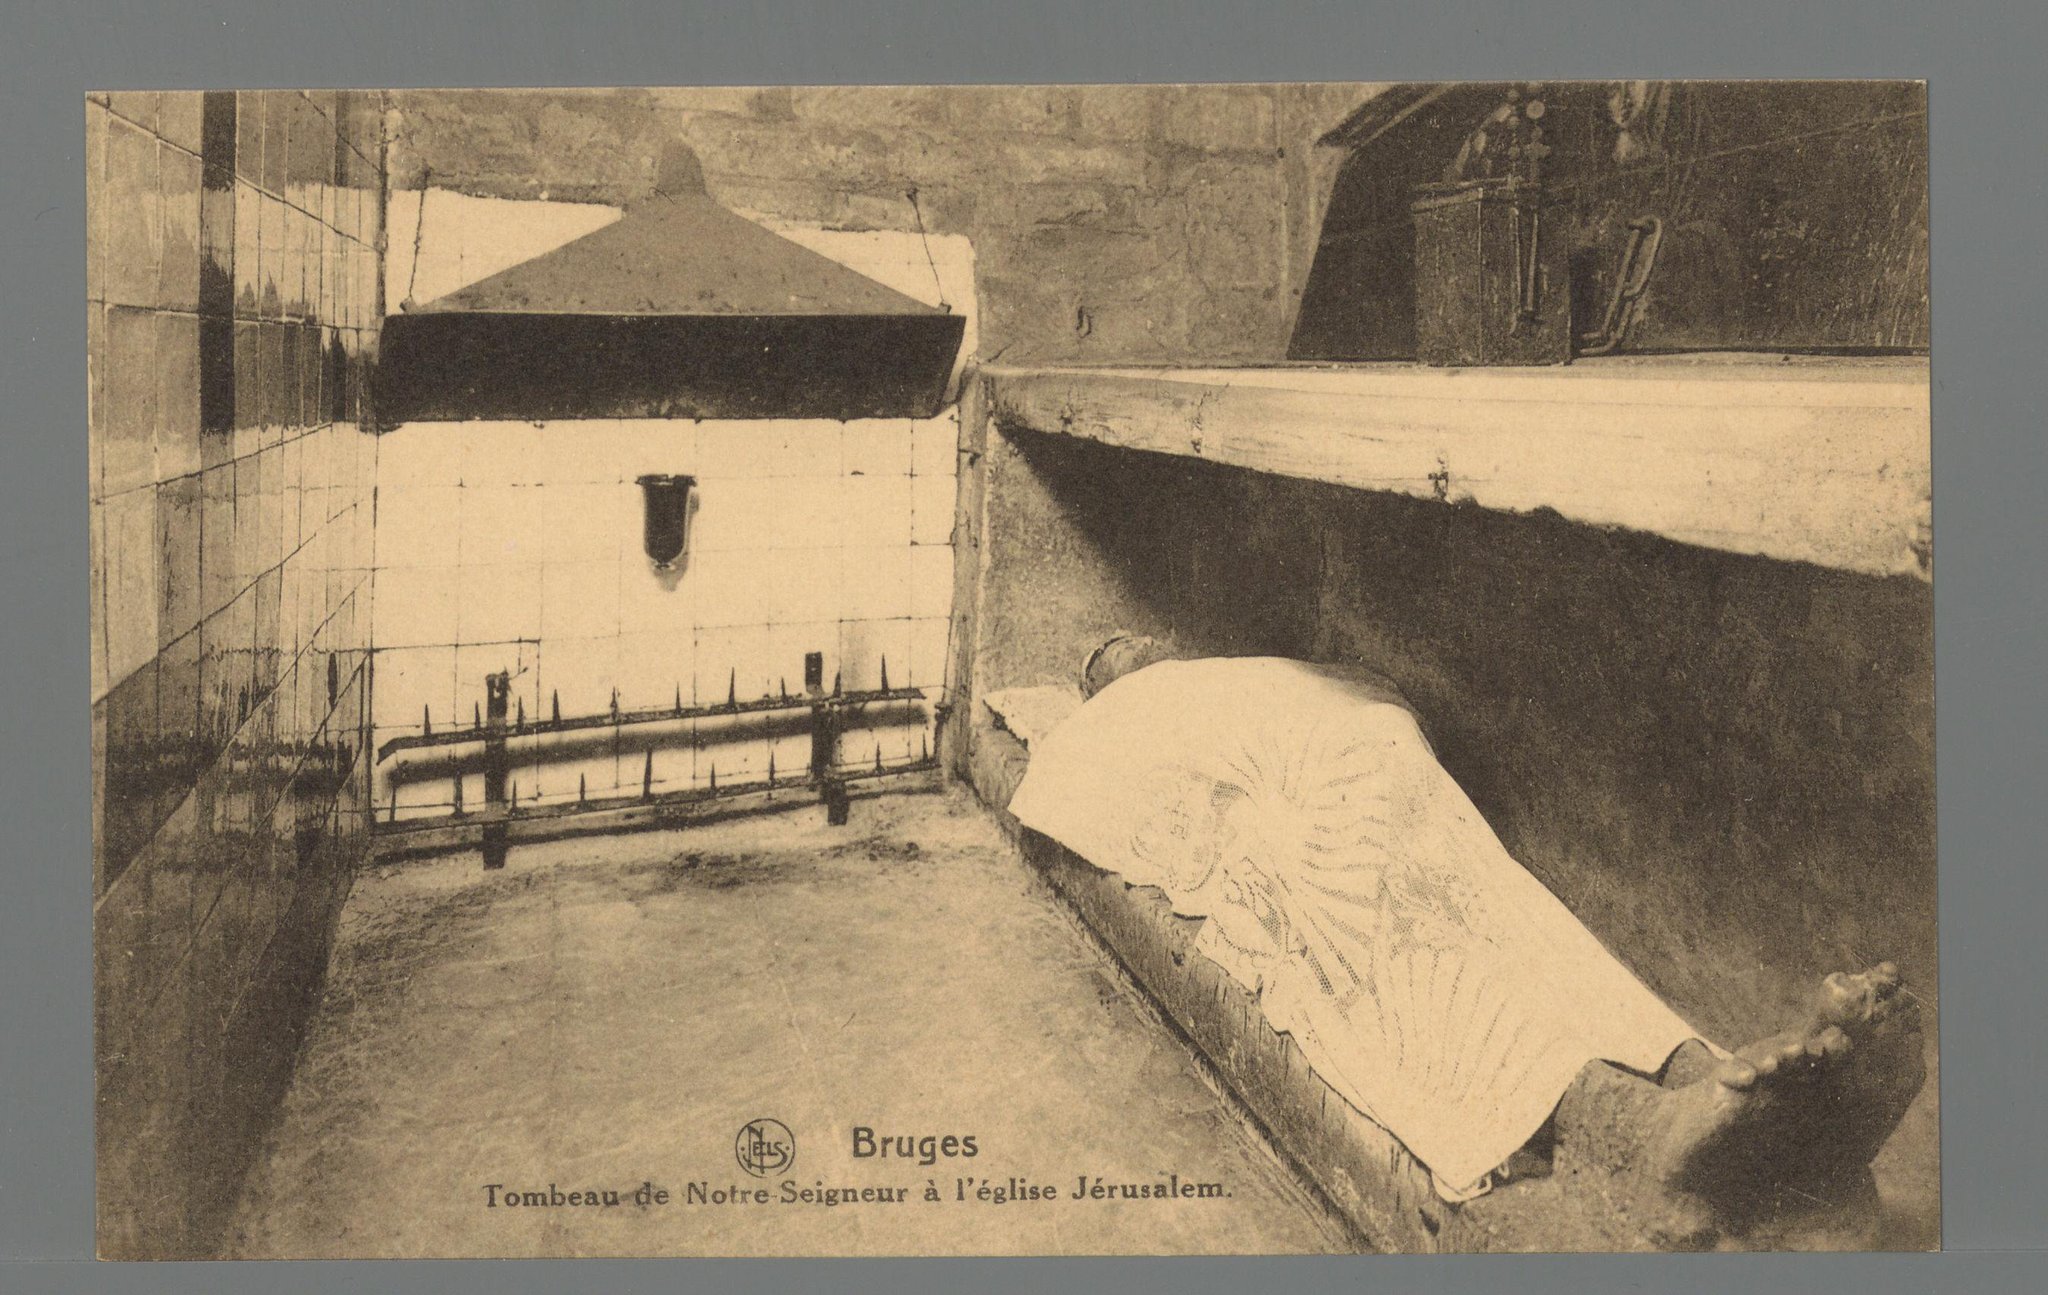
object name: photomechanical print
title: Bruges. Tombeau de Notre-Seigneur à l'église Jérusalem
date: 1907-1930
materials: cardboard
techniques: photograph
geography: bruges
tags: grave, tomb, interior of church